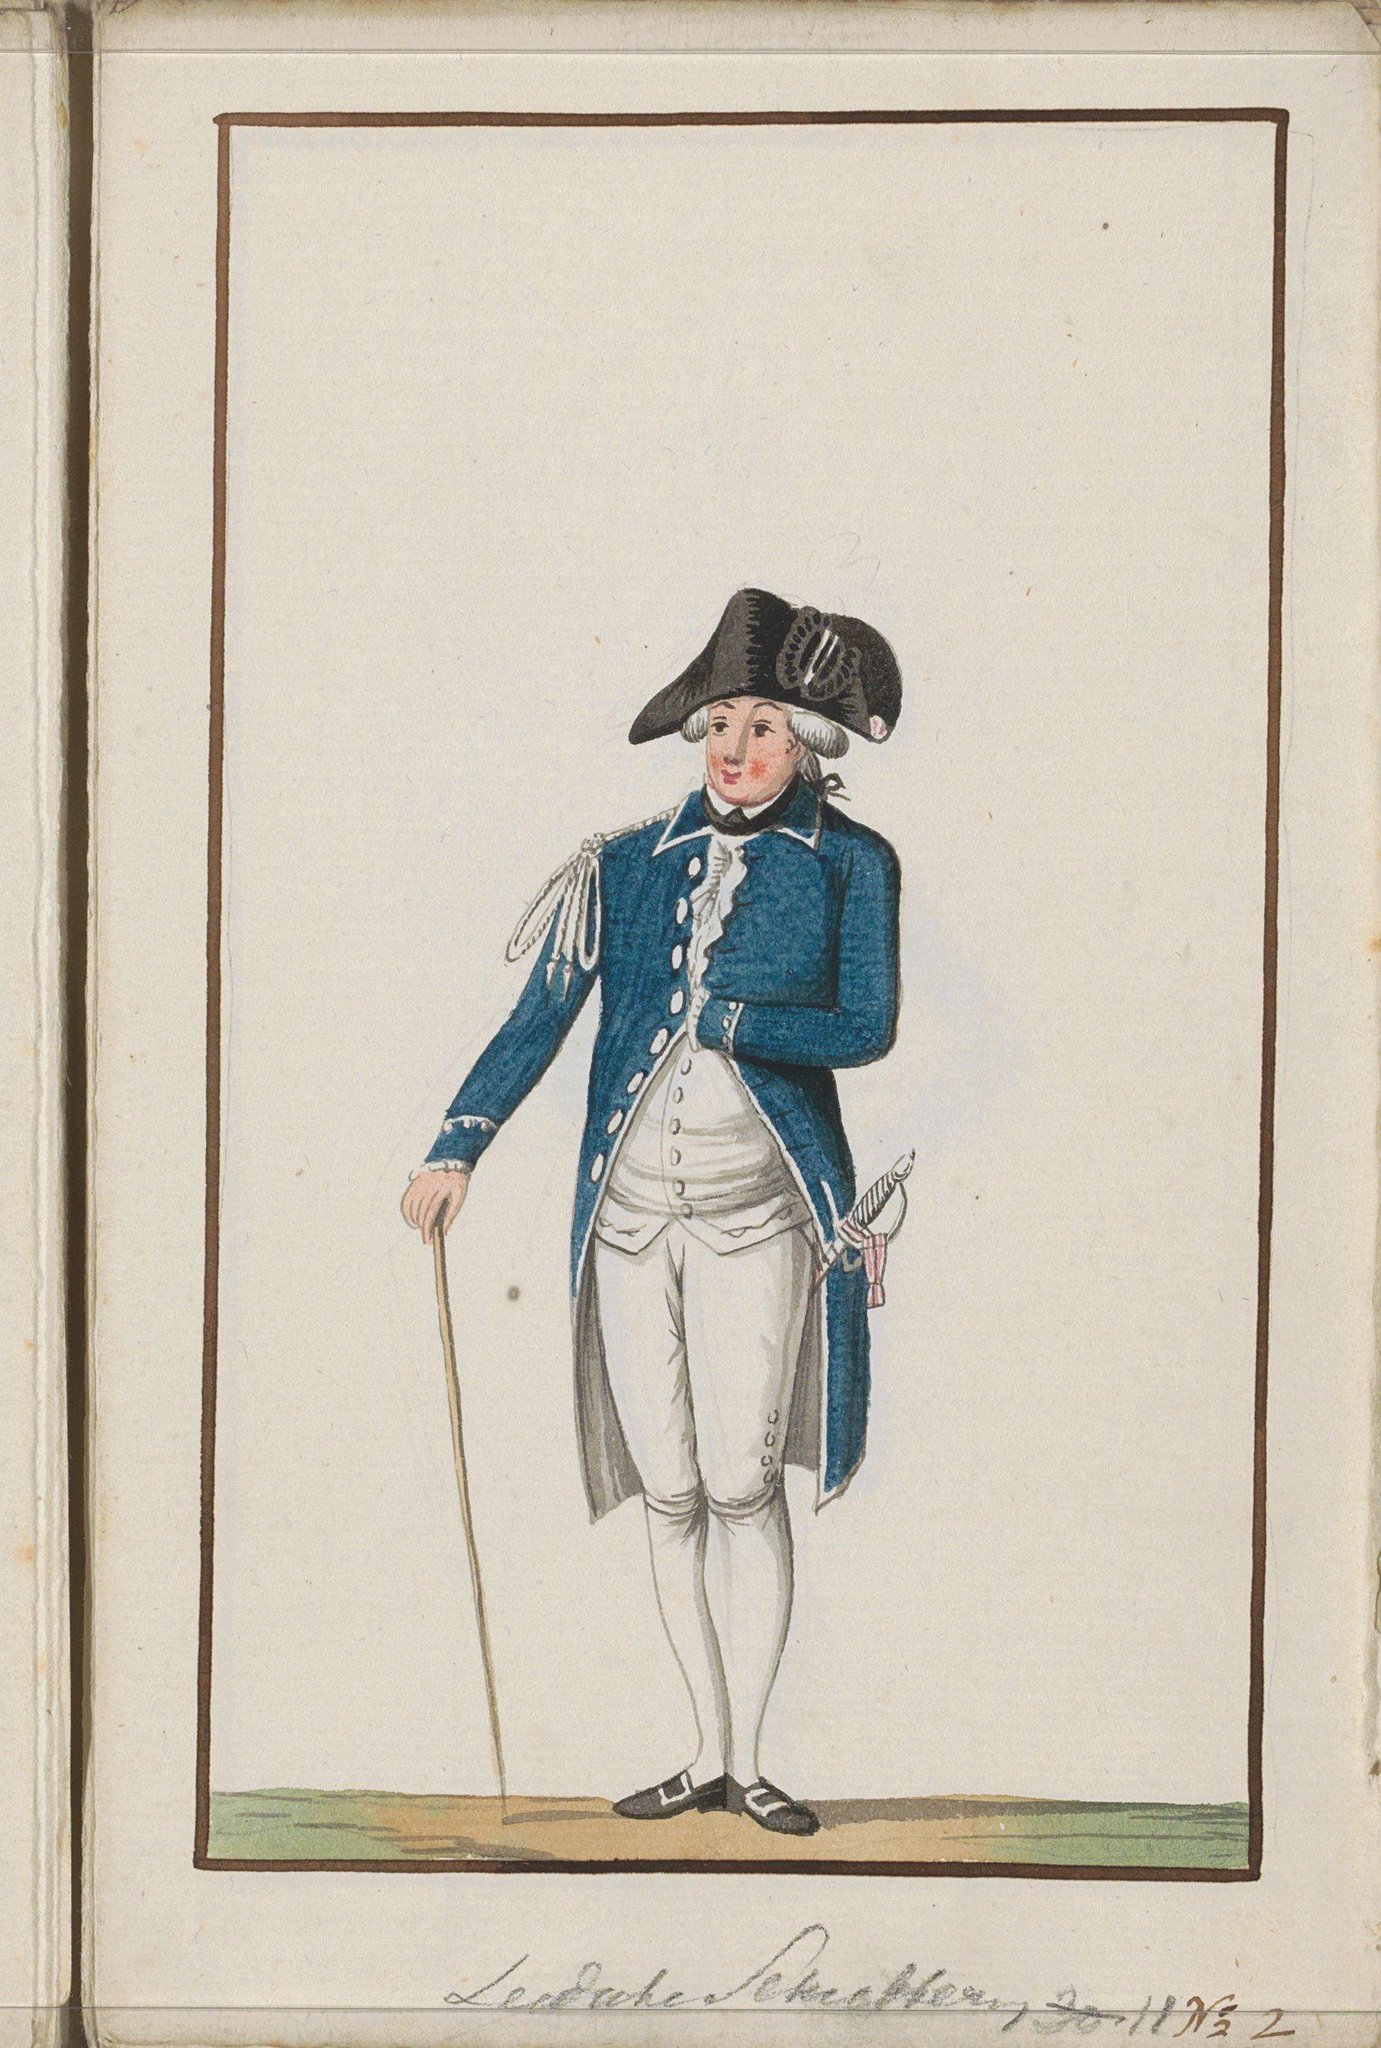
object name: drawing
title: Leyde schuttery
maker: Anonymous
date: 1789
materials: paper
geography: northern netherlands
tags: (military) uniforms (+ citizen soldiery, civil guard, citizen militia), leiden, patriots (1780-1795)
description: Montering of uniform van de schutterij van Leiden, ca. 1785. Onderdeel van een schetsboek met 41 gekleurde tekeningen van de monteringen van de gewapende schutterijen en burgercorpsen in Nederland in de periode ca. 1783-1789.